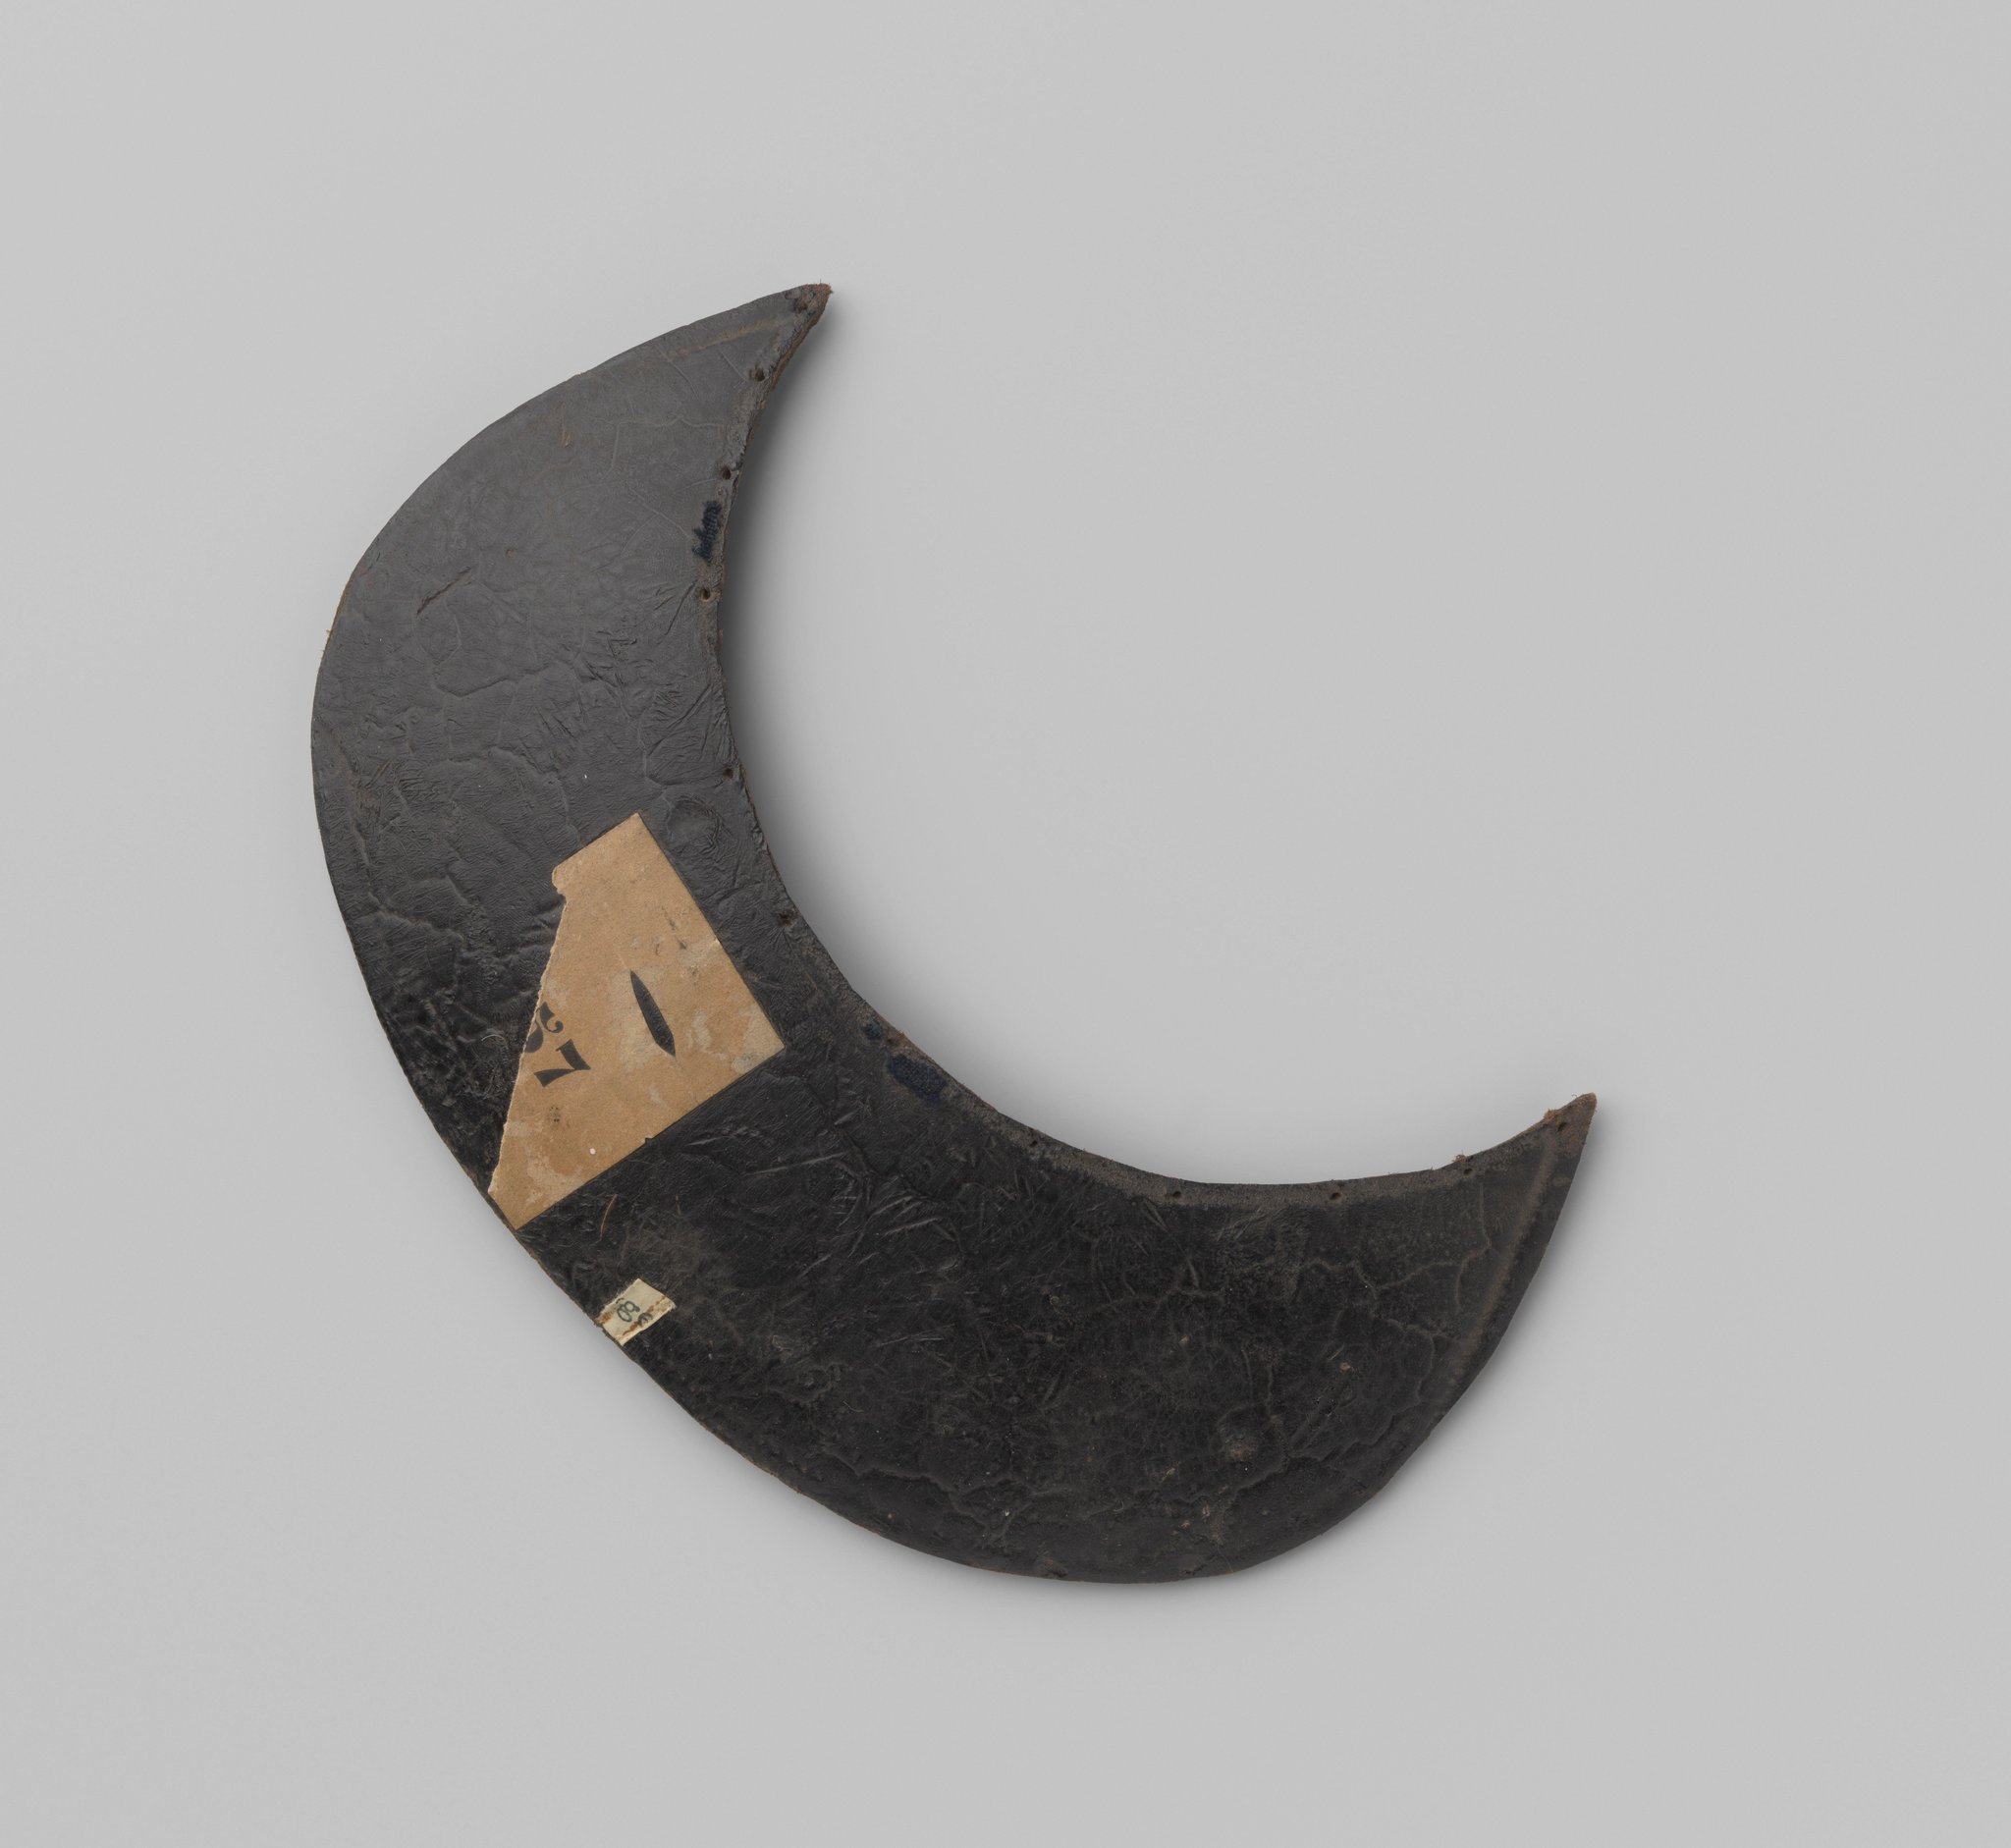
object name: garrison cap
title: Kwartiermuts - klep van jonkheer G.P.C. van Breugel, officier mobiele Noord Hollandse schutterij, ca. 1830-1832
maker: Anonymous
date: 1830-1832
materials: leather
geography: netherlands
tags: jonkheer g.p.c. van breugel, koninklijke landmacht, noord-hollandse schutterij, noord-holland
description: Blauw lakense pet met rode band en bies, leren klep. Afkomstig van Breughel in 1830-1832 1e luitenant : 1e bataljon ; 2e afdeling : mobiele Noord-Hollandse schutterij. Ernstig door de mot aangetast. Pet mankeert?